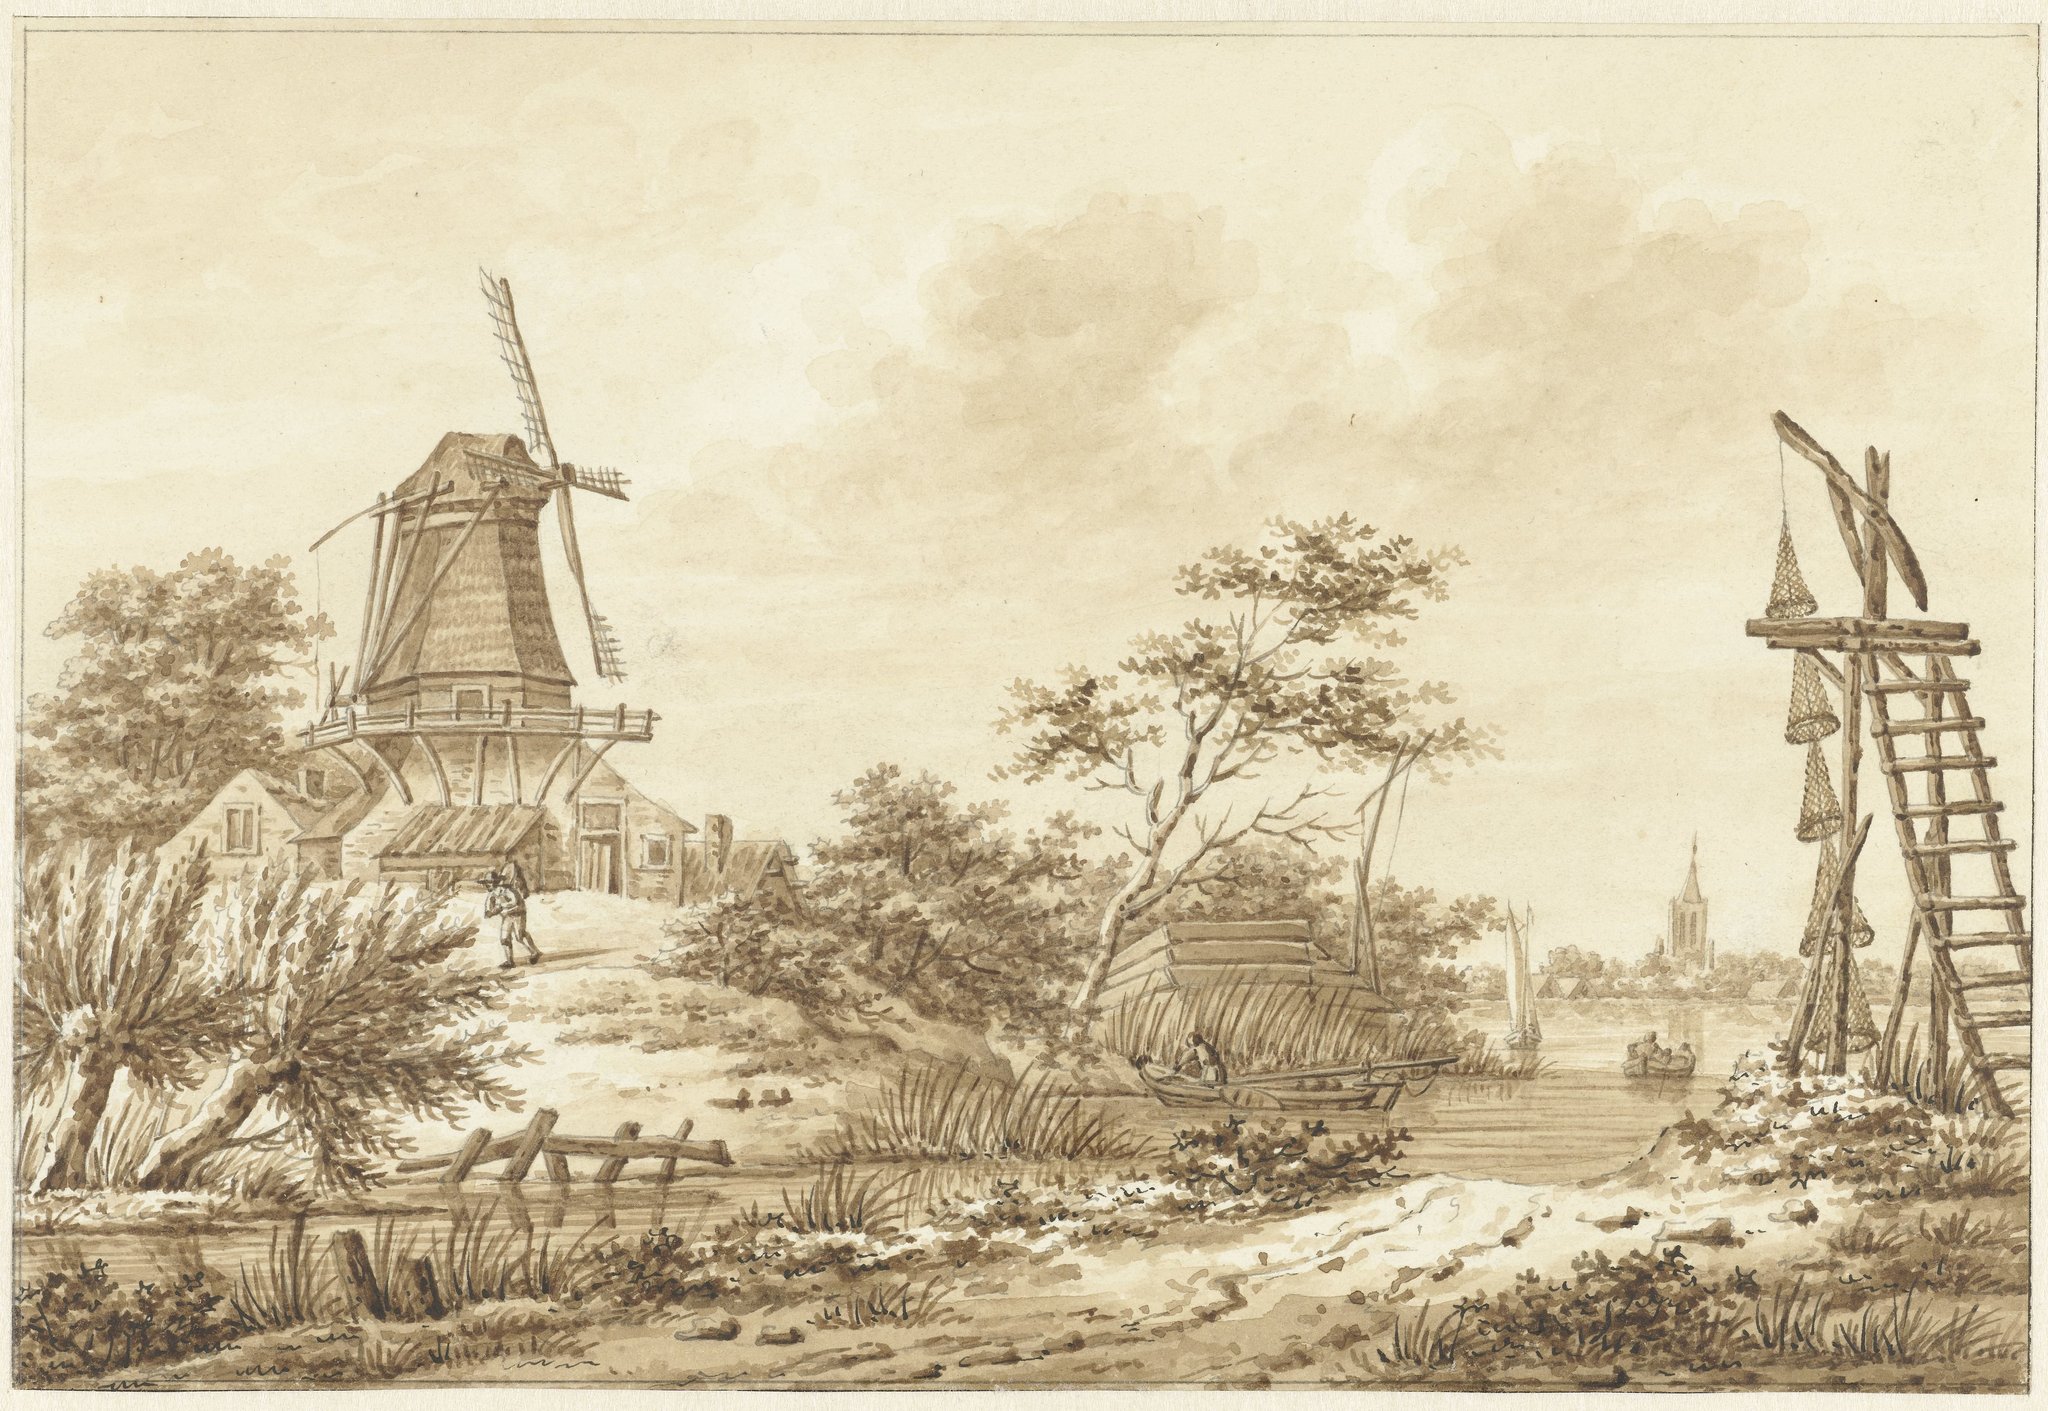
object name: drawing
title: Gezicht bij Zaltbommel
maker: hermanus numan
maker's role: draughtsman, painter, print maker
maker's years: 1744-1820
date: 1754-1820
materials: ink, paper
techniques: brush, pen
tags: windmill